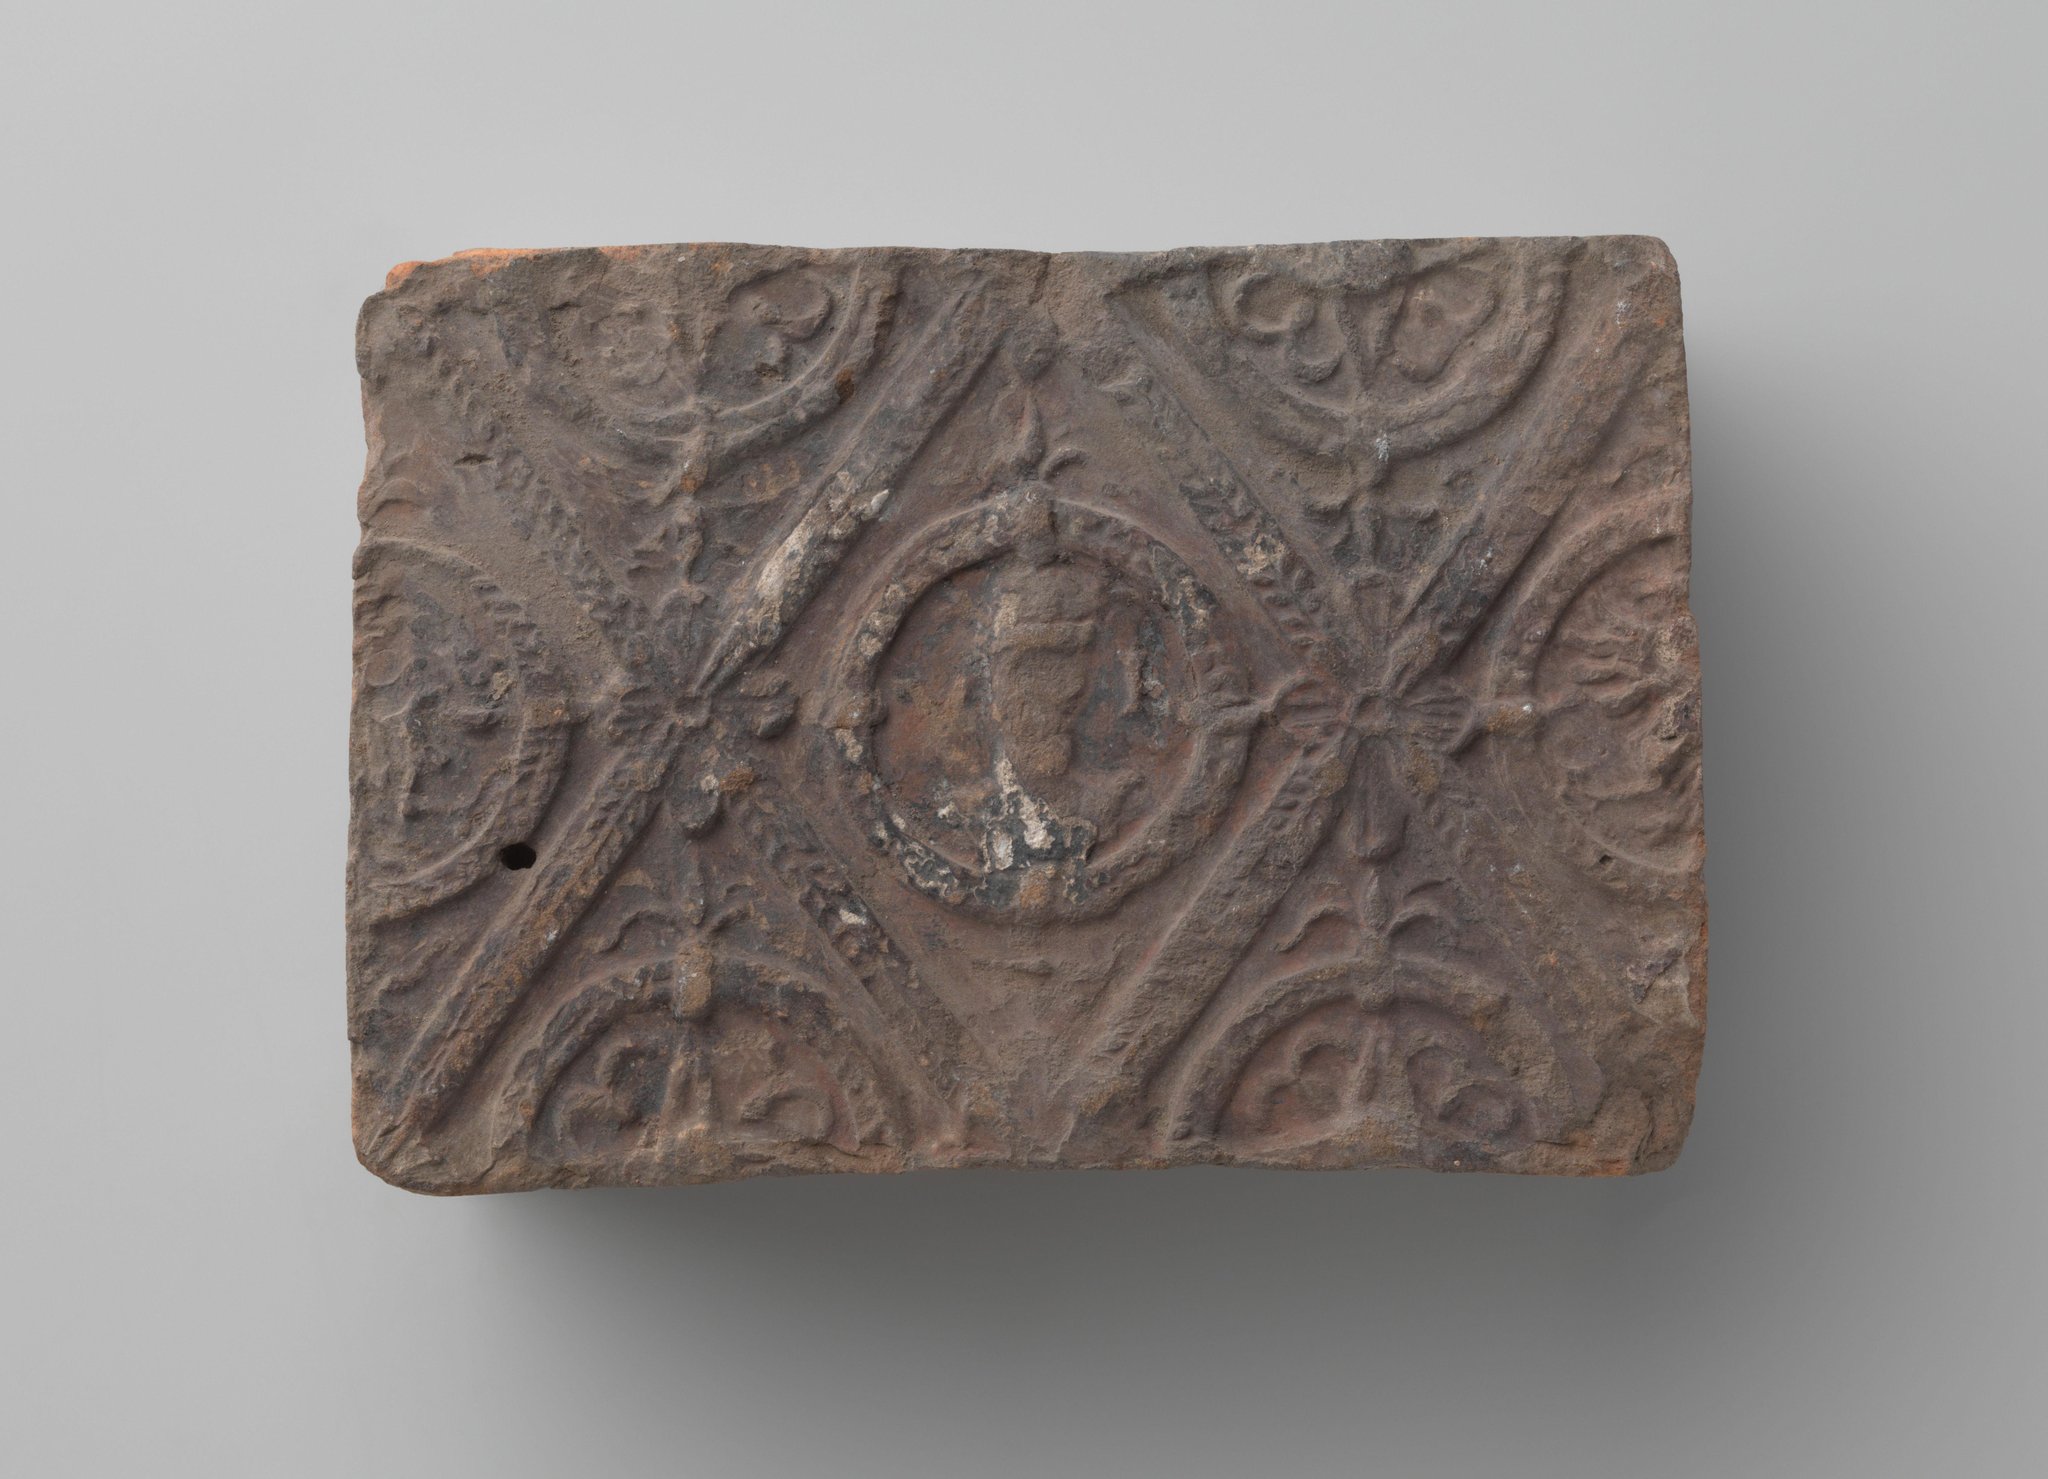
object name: hearthstone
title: Haardsteen met mannenkop en de letters V I in lauwerkrans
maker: Anonymous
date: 1575-1625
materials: earthenware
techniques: printing, firing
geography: southern netherlands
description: Haardsteen met voorstelling van mannenkop en de letters V I in lauwerkrans, geplaatst in geprofileerde ruit. In de halve ruiten aan de zijkanten een dubbelkoppige adelaar. De halve ruiten aan de boven- en onderkant zijn opgevuld met halve medaillons met stermotief.